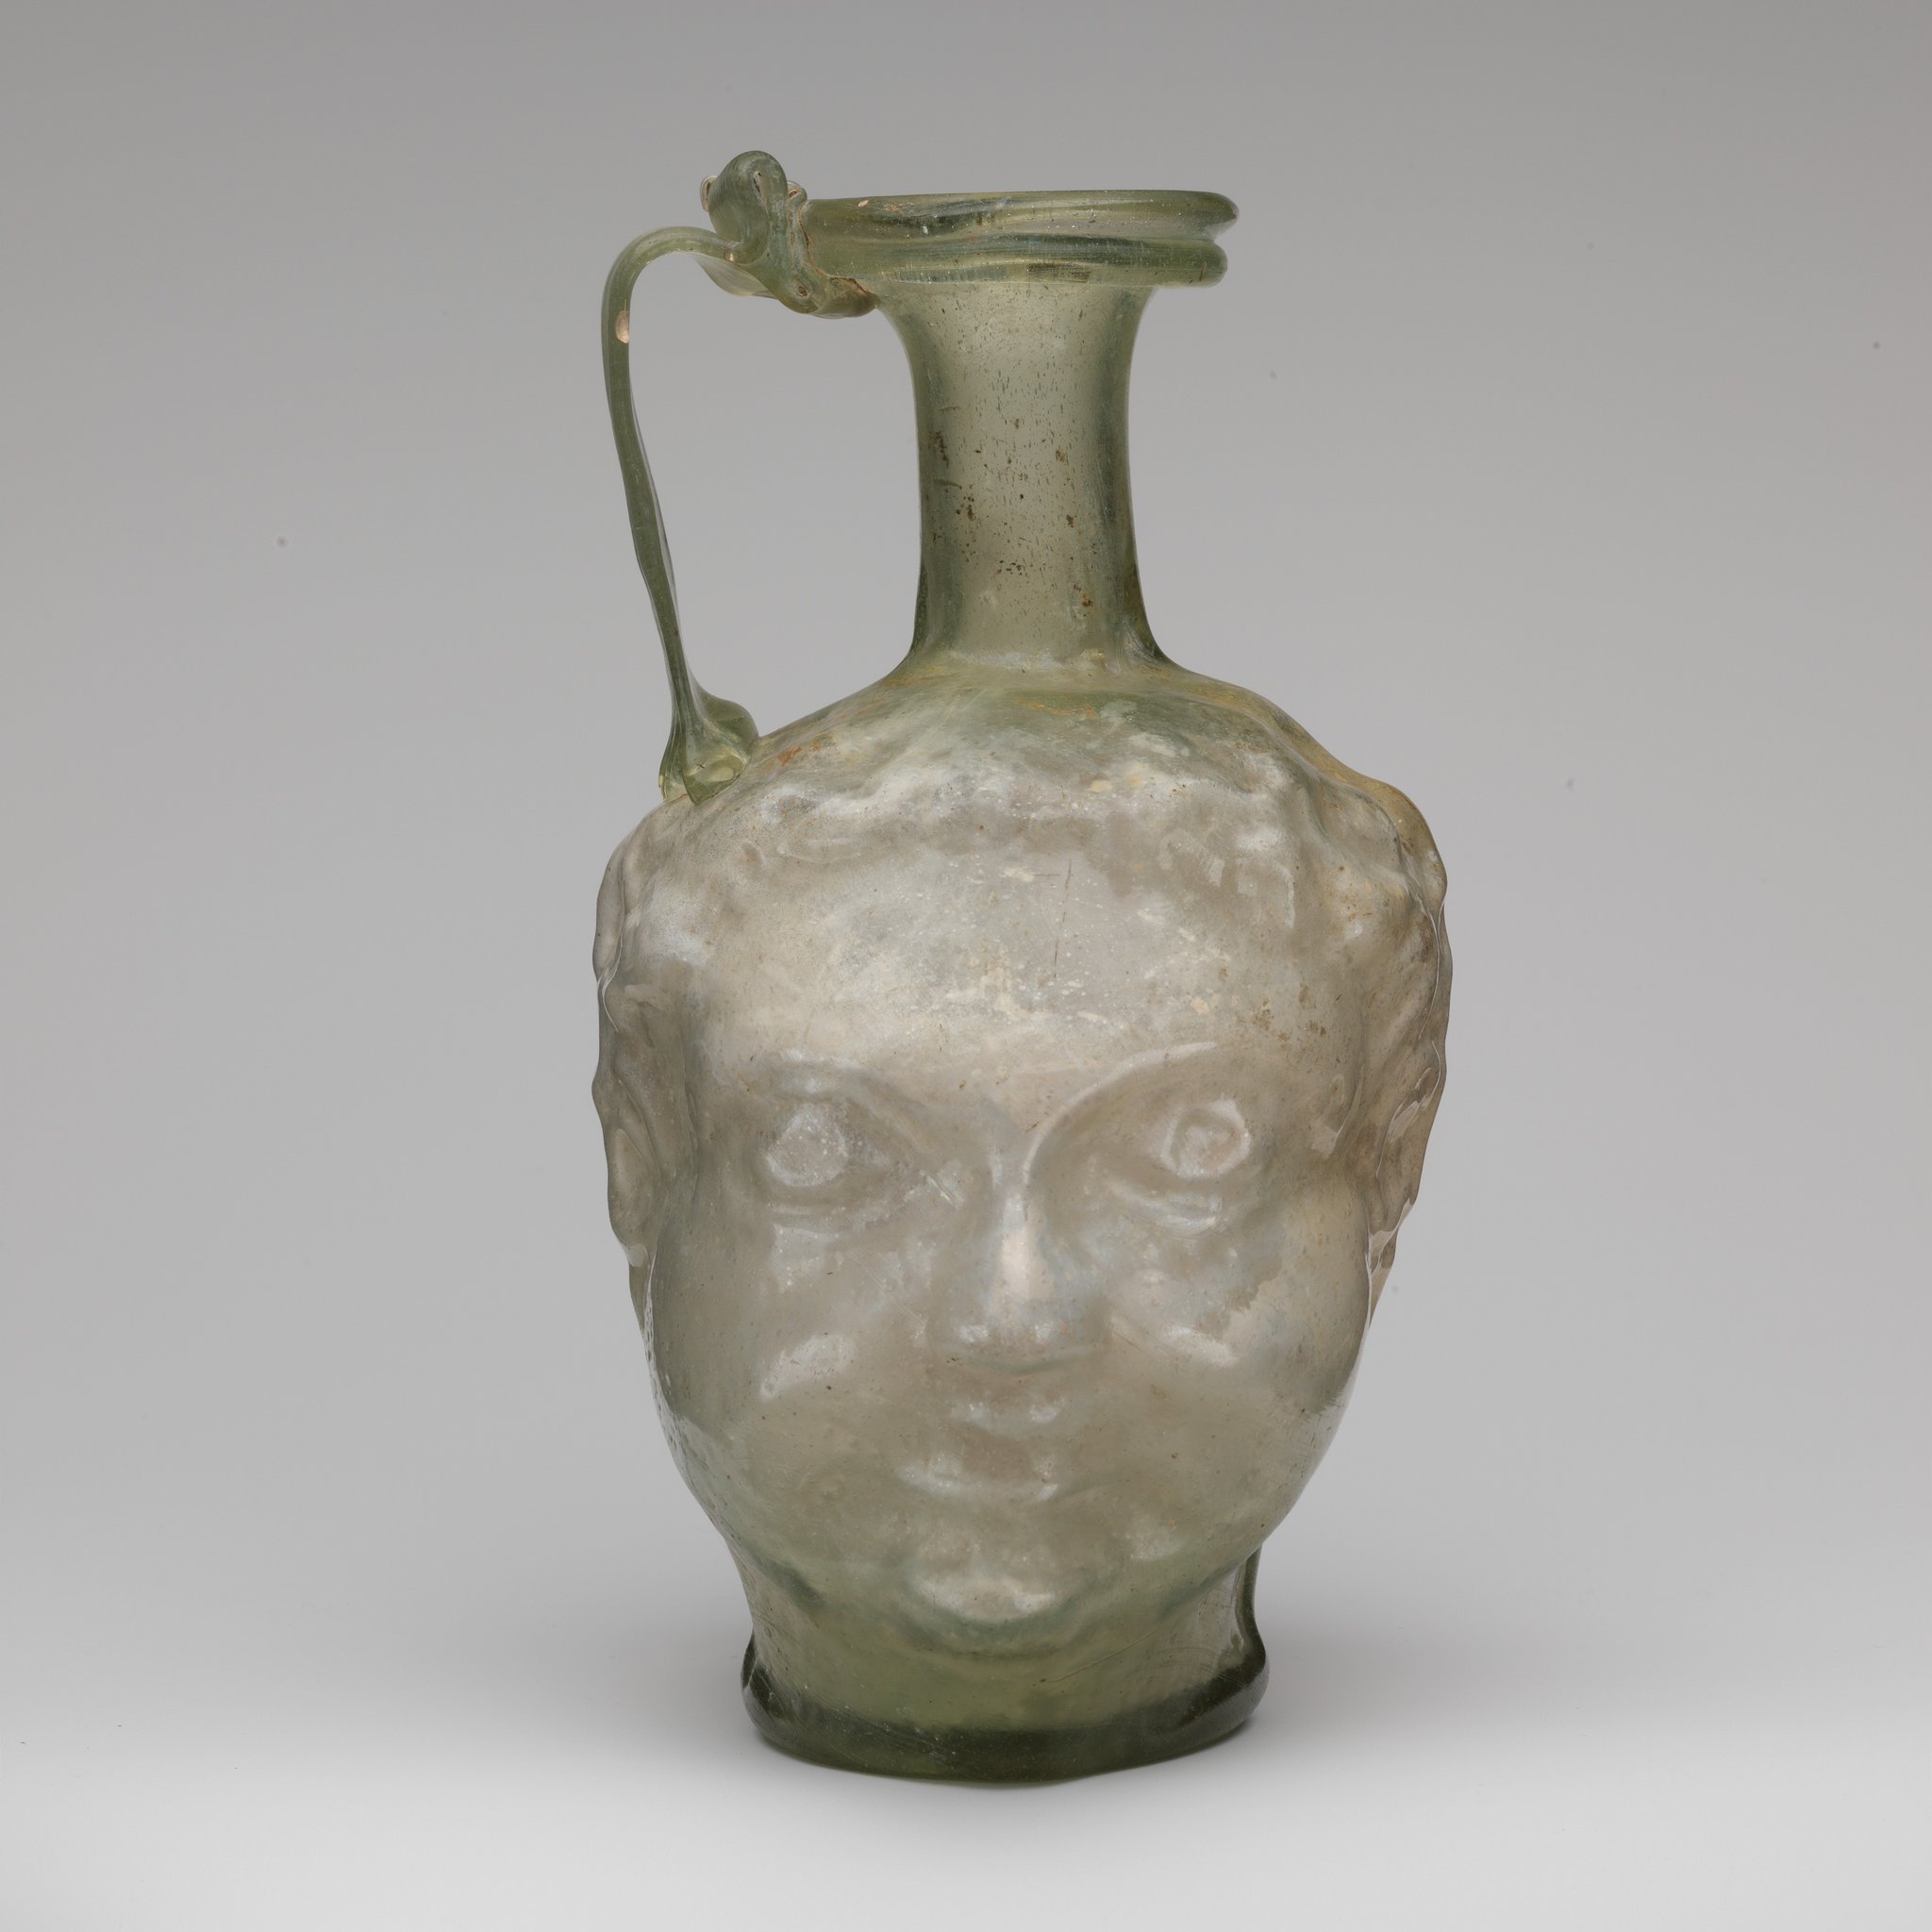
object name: flask, double head shaped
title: Glass double head-shaped flask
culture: roman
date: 301-350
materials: glass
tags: heads